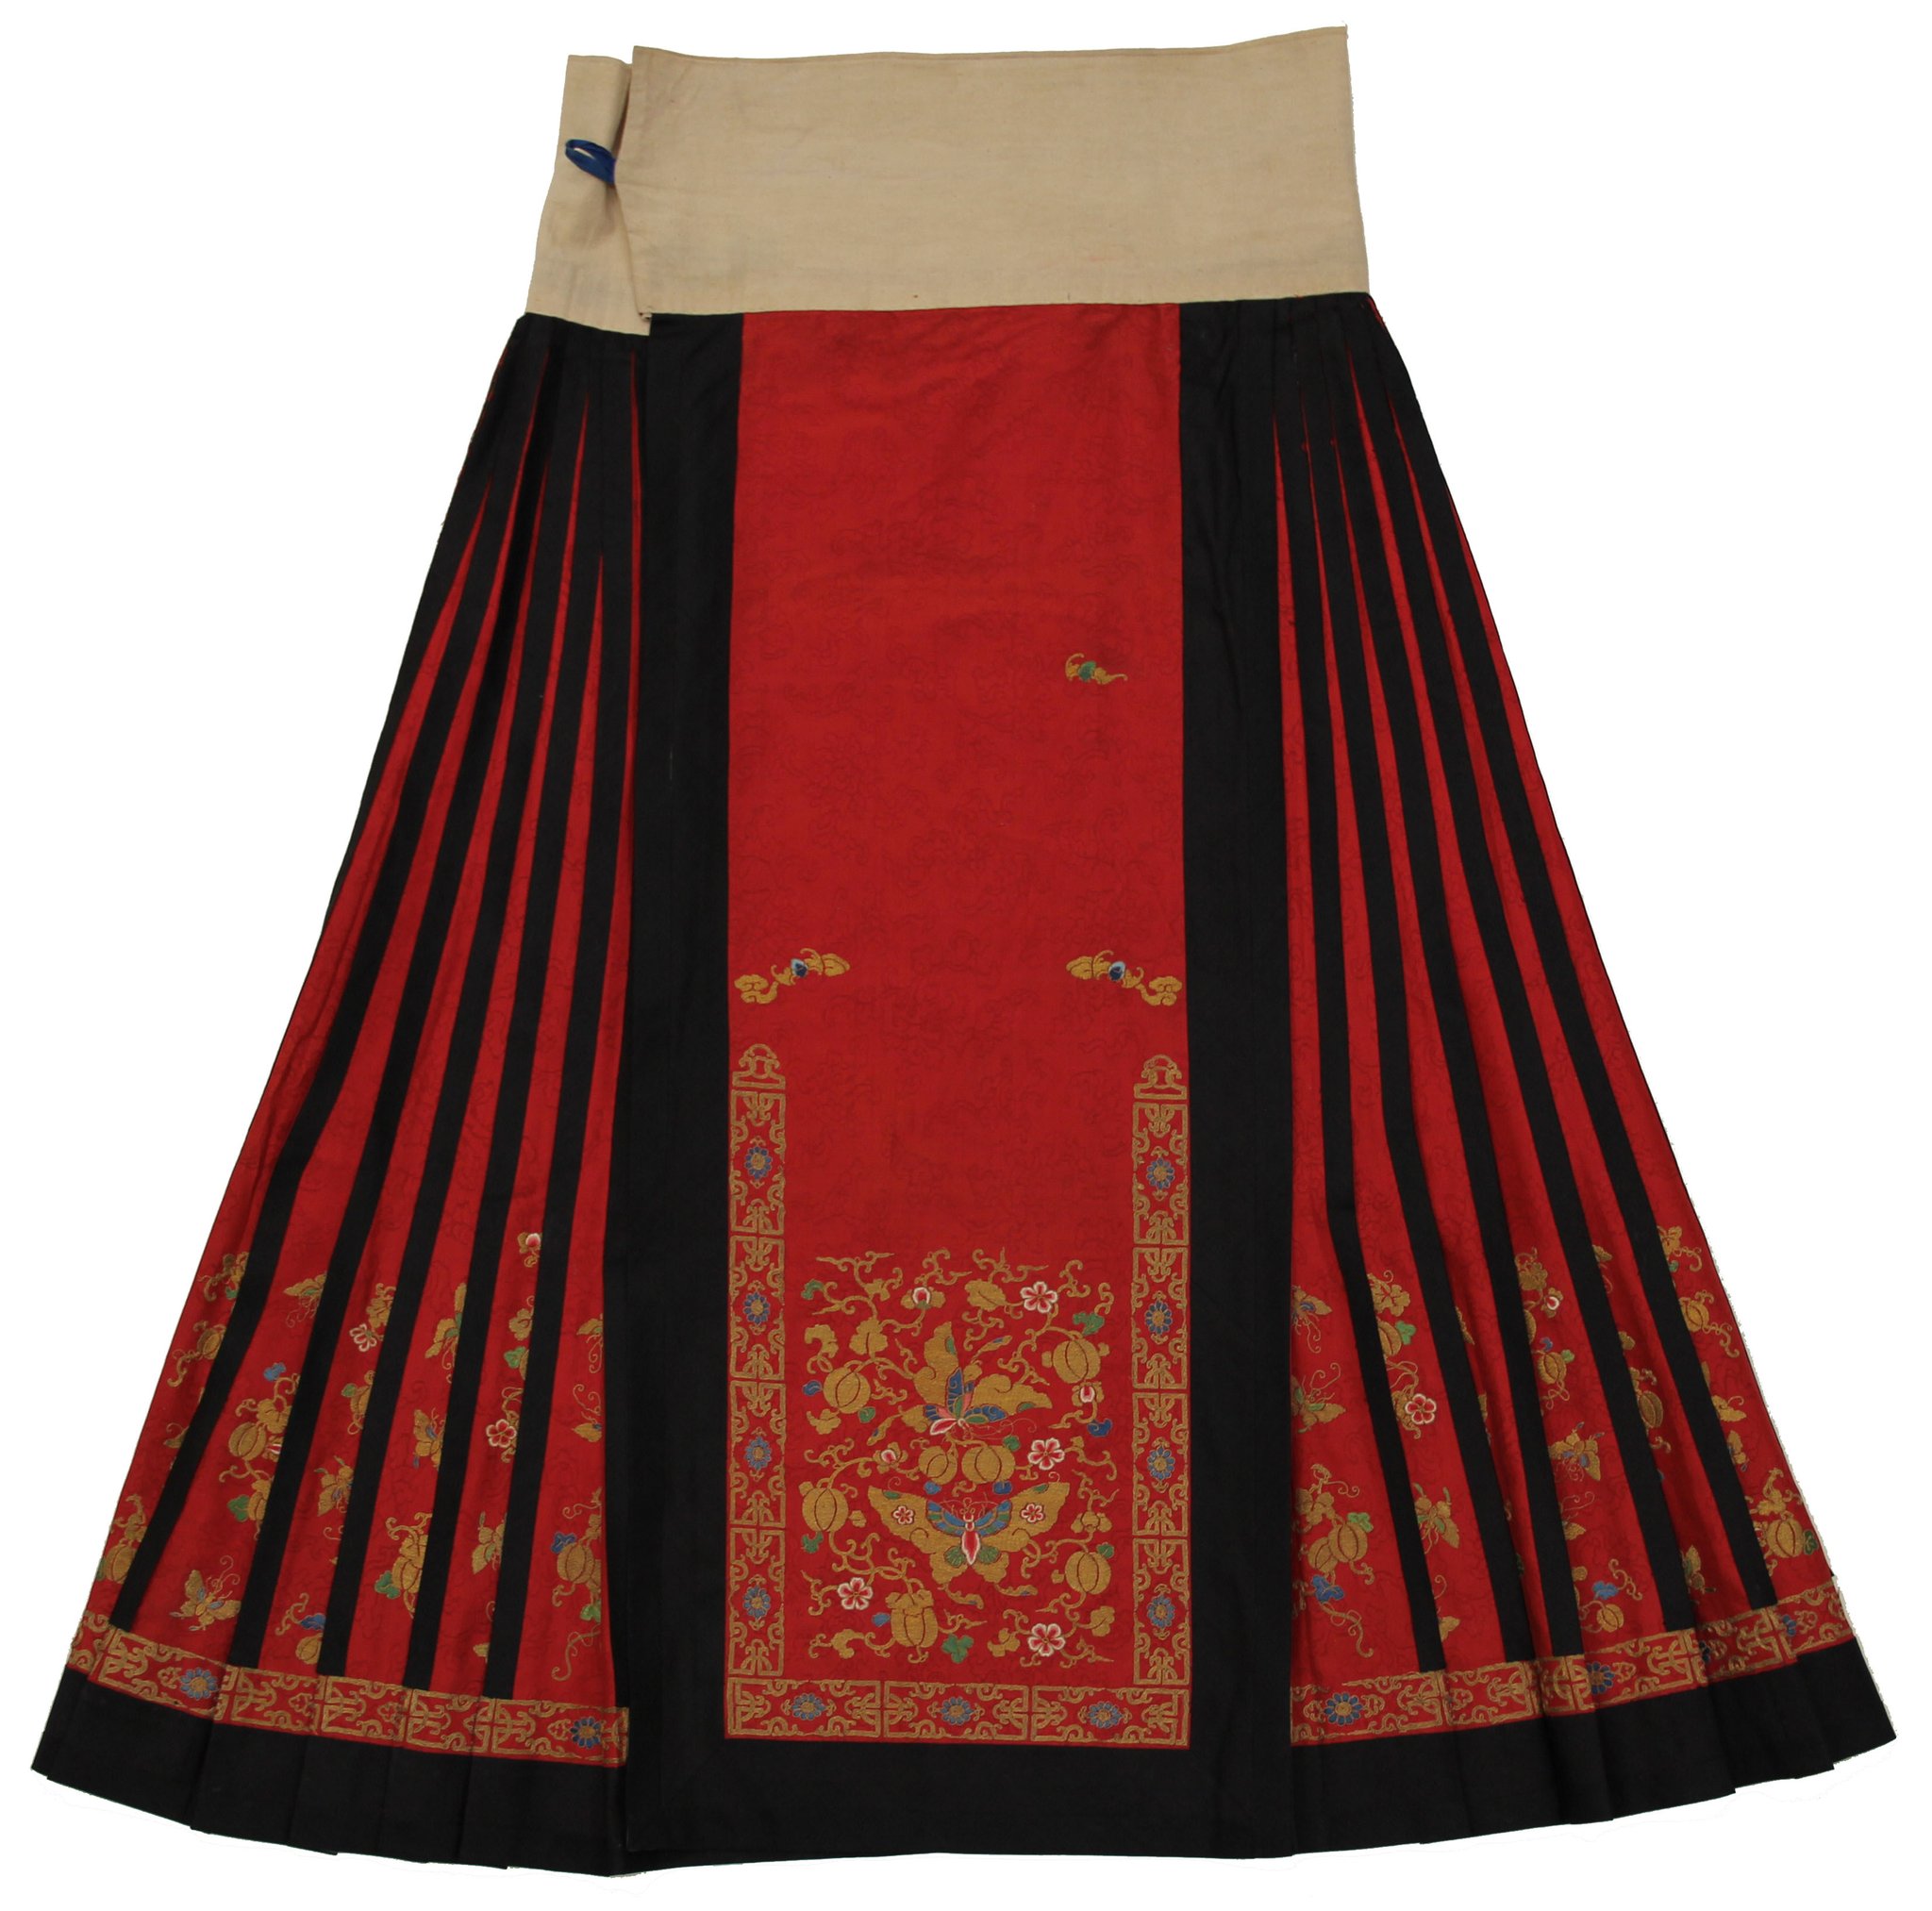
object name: skirt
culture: chinese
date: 1801-1900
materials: metal thread, silk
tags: bats,flowers